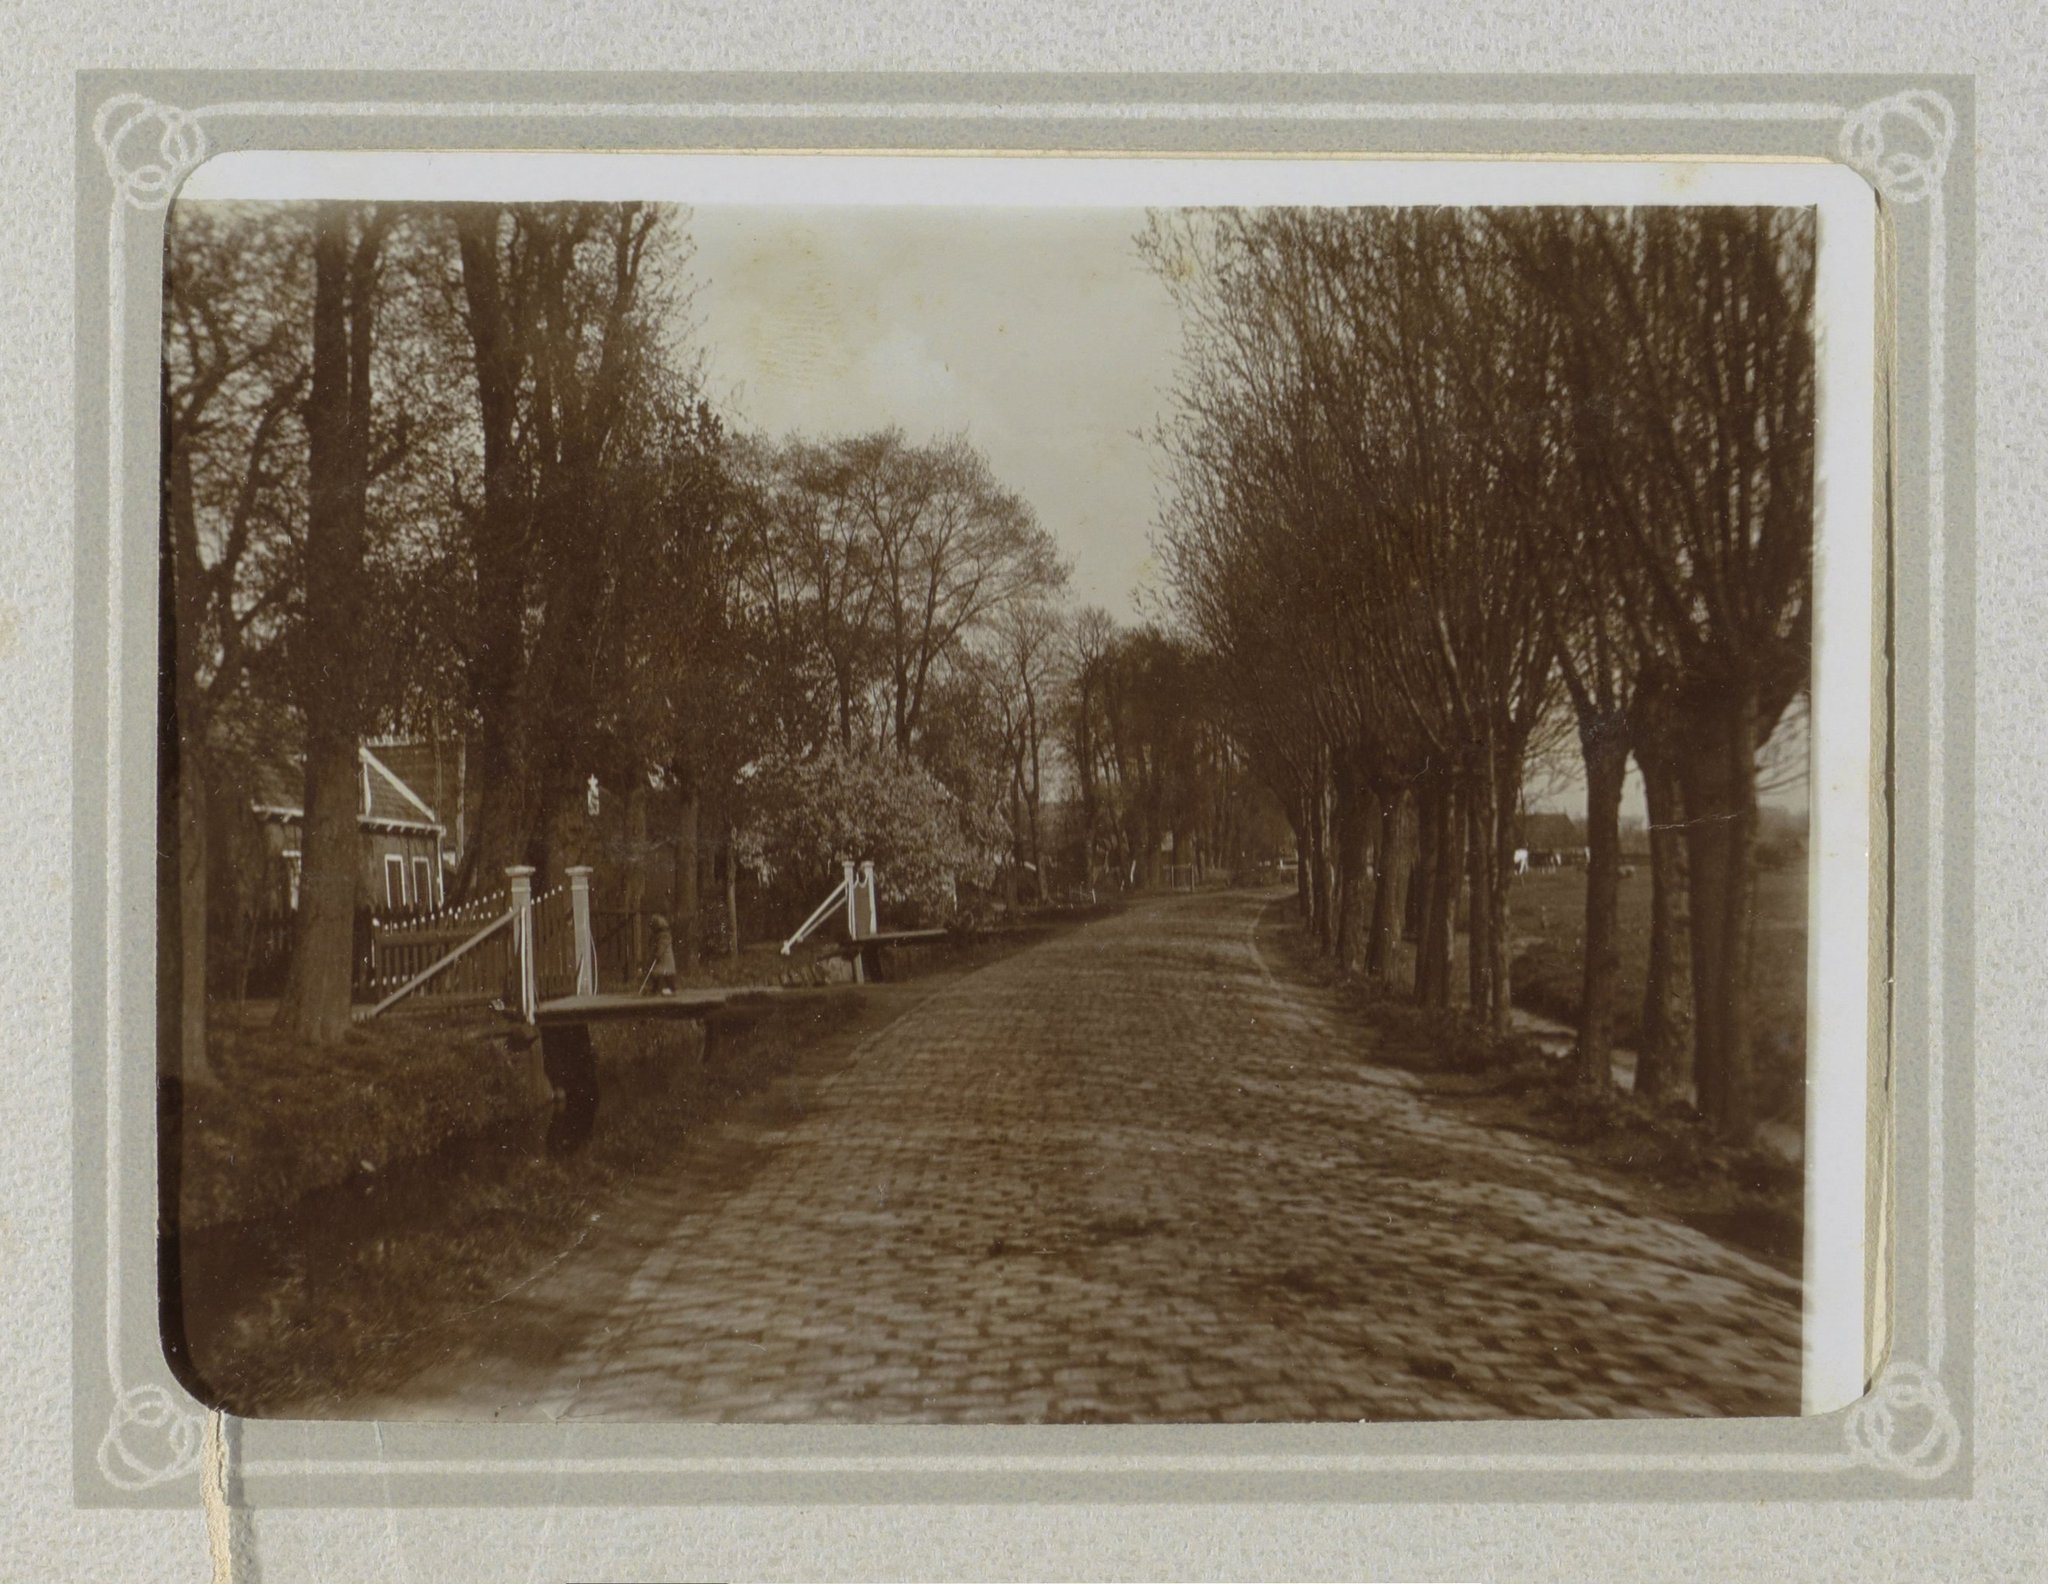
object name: photograph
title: Klinkerweg met bomen, huizen en toegangspoorten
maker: folkert idzes de jong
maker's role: architect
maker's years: 1877-1929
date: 1905-1907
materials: photographic support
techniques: collodion silver print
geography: netherlands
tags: trees, public road (+ variant), rural housing, e.g. country-house, villa, cottage, gate, entrance, netherlands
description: Onderdeel van Topografisch album van Nederlandse dorpen en steden 1905.